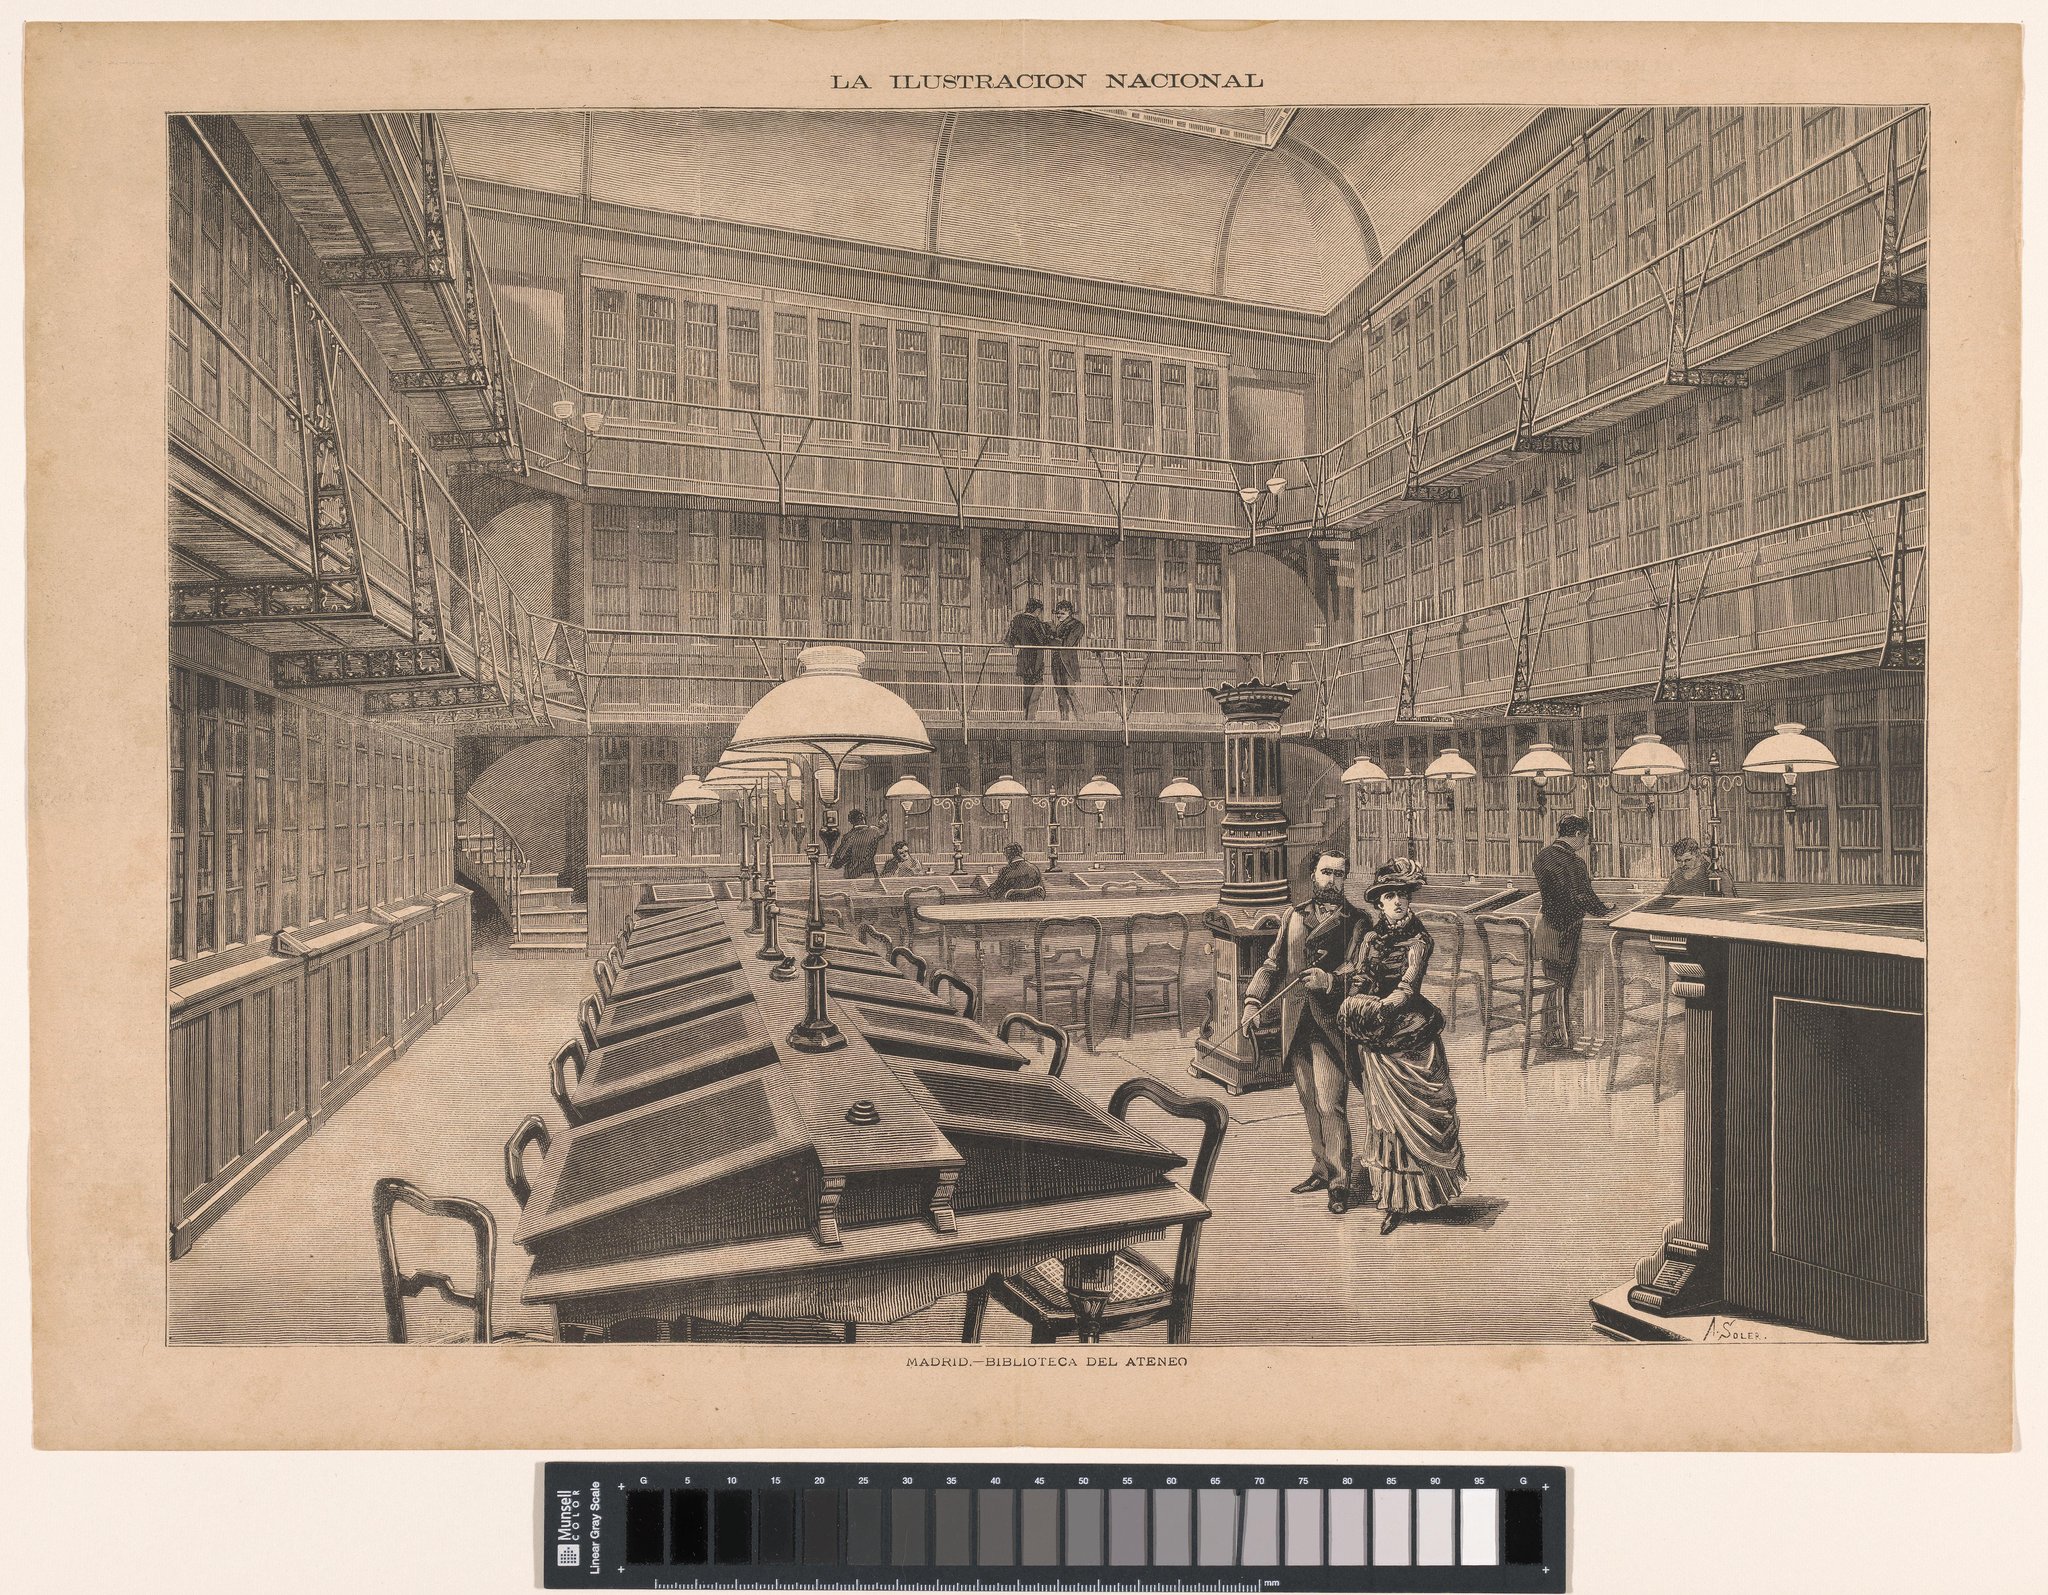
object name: print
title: Interieur van de bibliotheek van de Ateneo de Madrid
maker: a. soler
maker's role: print maker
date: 1850-1900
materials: paper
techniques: engraving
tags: public library, heating stove, lectern ~ reading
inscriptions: collector's mark: Lugt 2228, collector's mark: Lugt 4779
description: De boeken zijn verdeeld over drie niveaus, de bovenste niveaus zijn bereikbaar zijn door middel van een balustrade. In de bibliotheekzaal staan lessenaars. In het midden een kachel met ervoor een man en een vrouw. Tekst op verso.